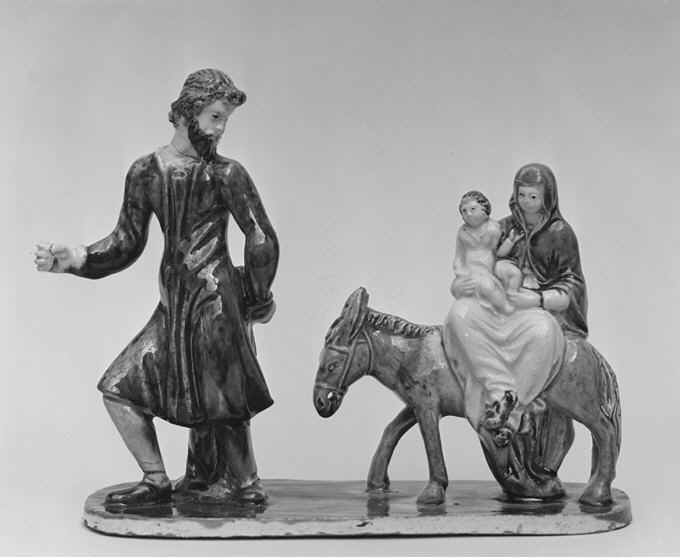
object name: group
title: Flight into Egypt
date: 1601-1633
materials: earthenware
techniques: glazing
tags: donkeys,holy family